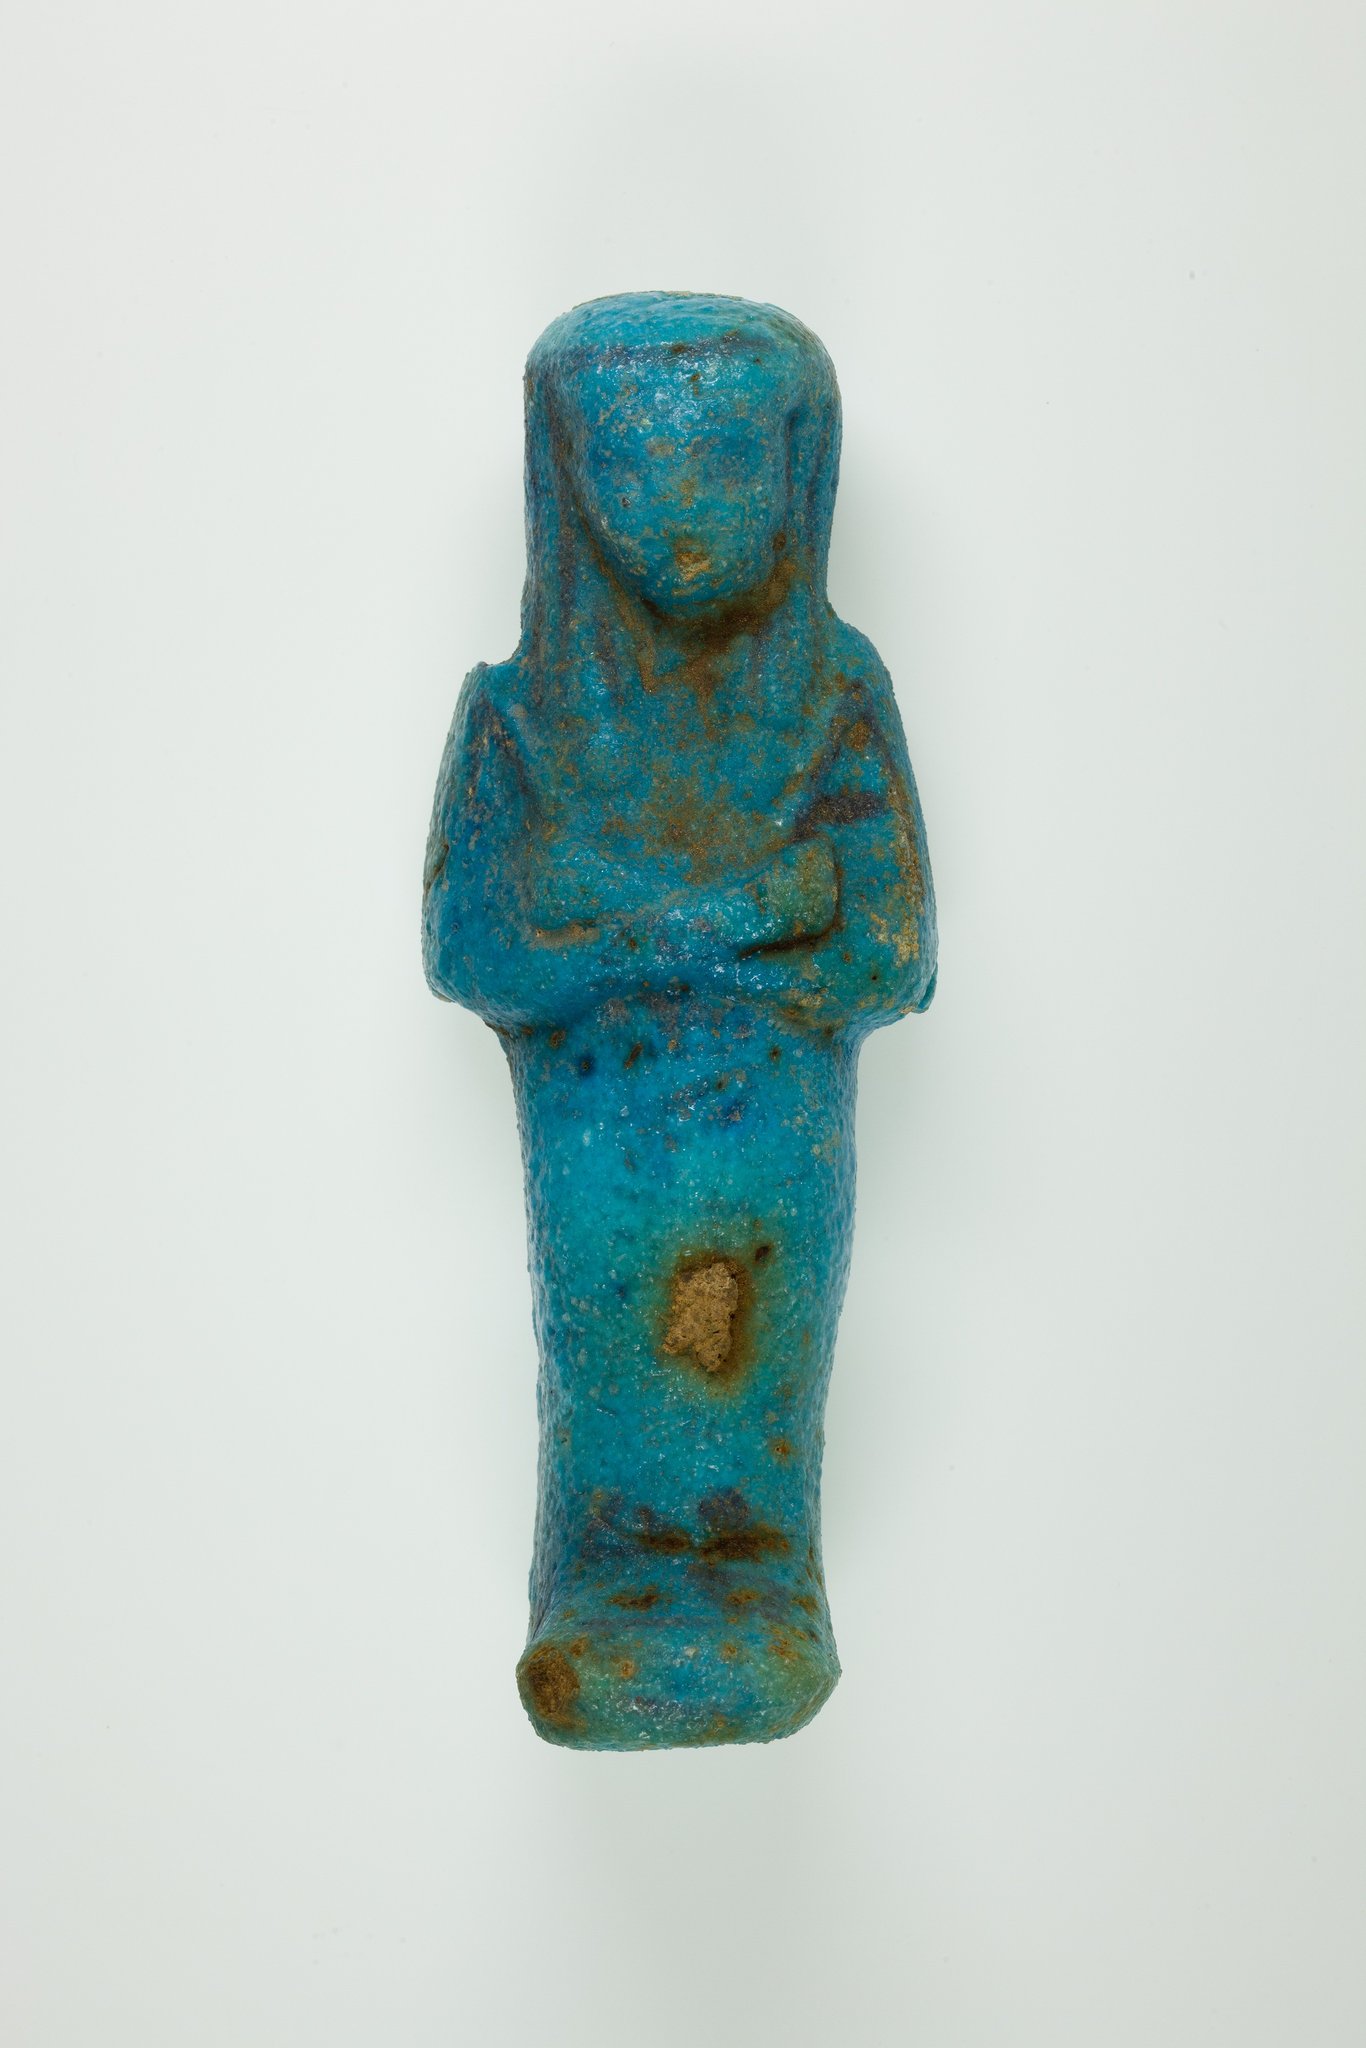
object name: worker shabti, henettawy c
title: Worker Shabti of Henettawy (C), Daughter of Isetemkheb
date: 990-970 BCE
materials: faience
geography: egypt